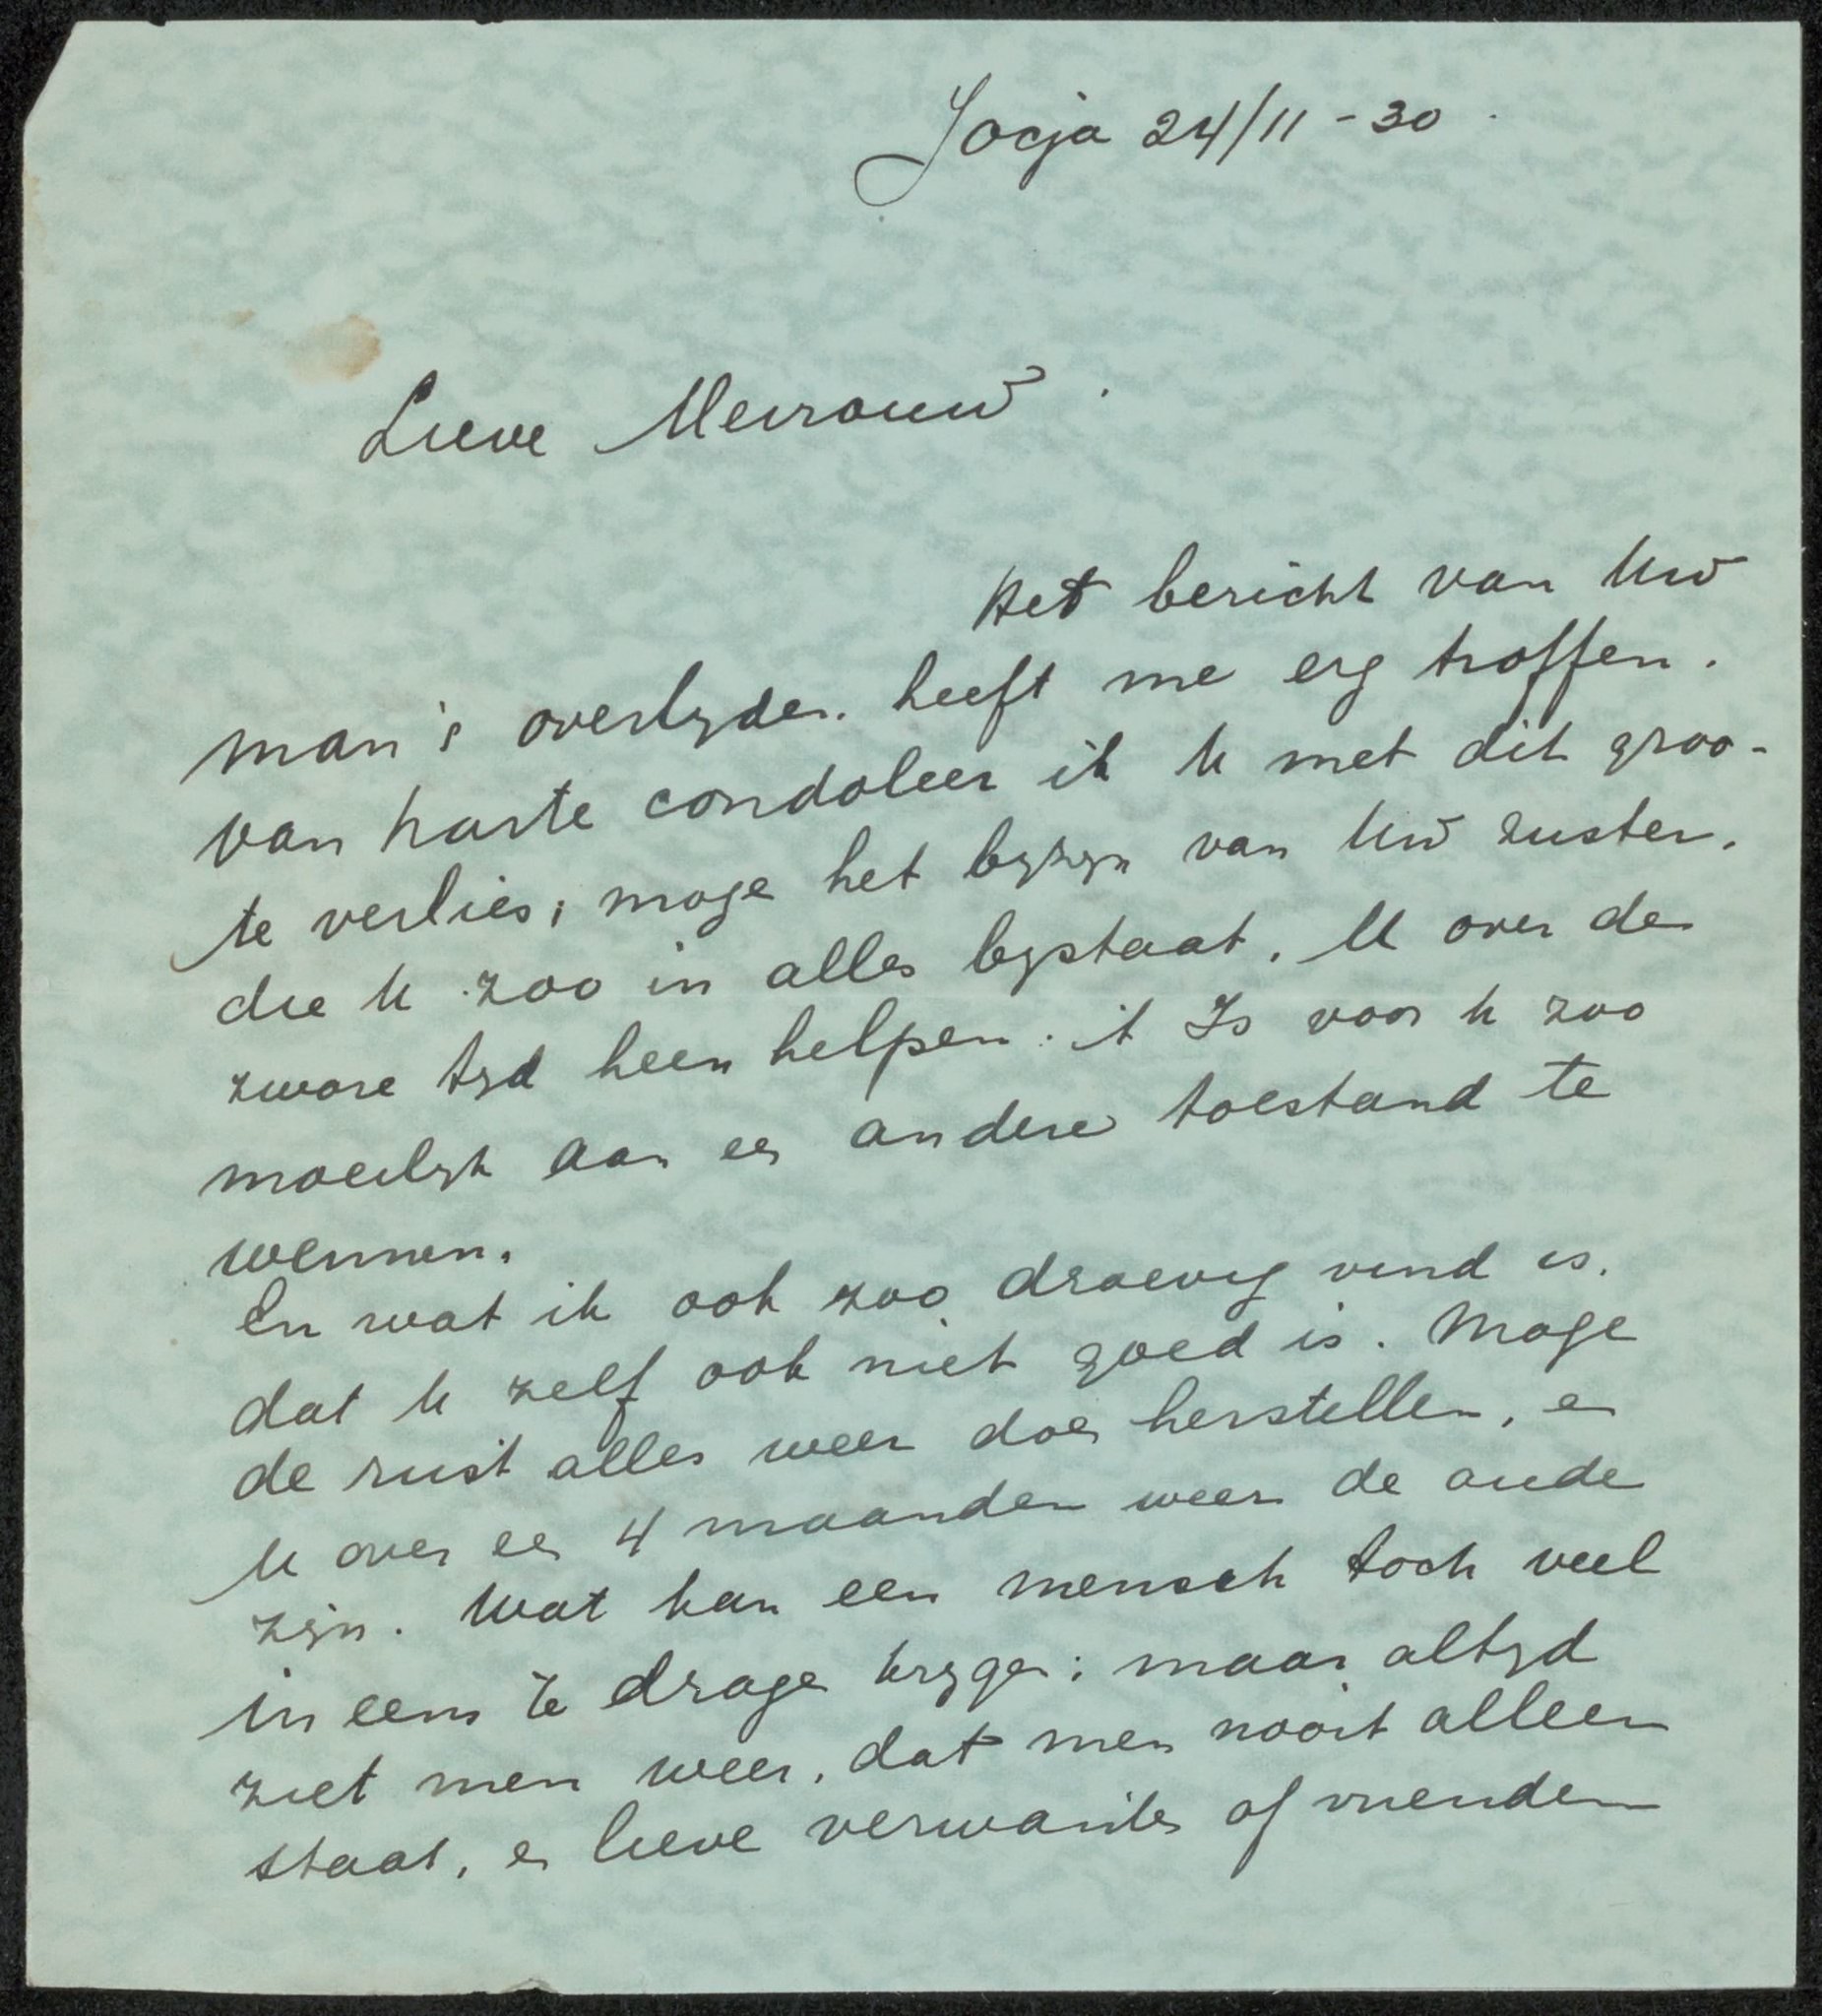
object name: letter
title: Brief aan Henriette Wilhelmina van Baak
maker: henriette marie gobée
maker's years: 1878-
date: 1930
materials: ink, paper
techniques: pen, writing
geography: jogjakarta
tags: henriette wilhelmina van baak, painter, draughtsman, philip zilcken, passions, emotions, affections, the graphic arts, family life, money